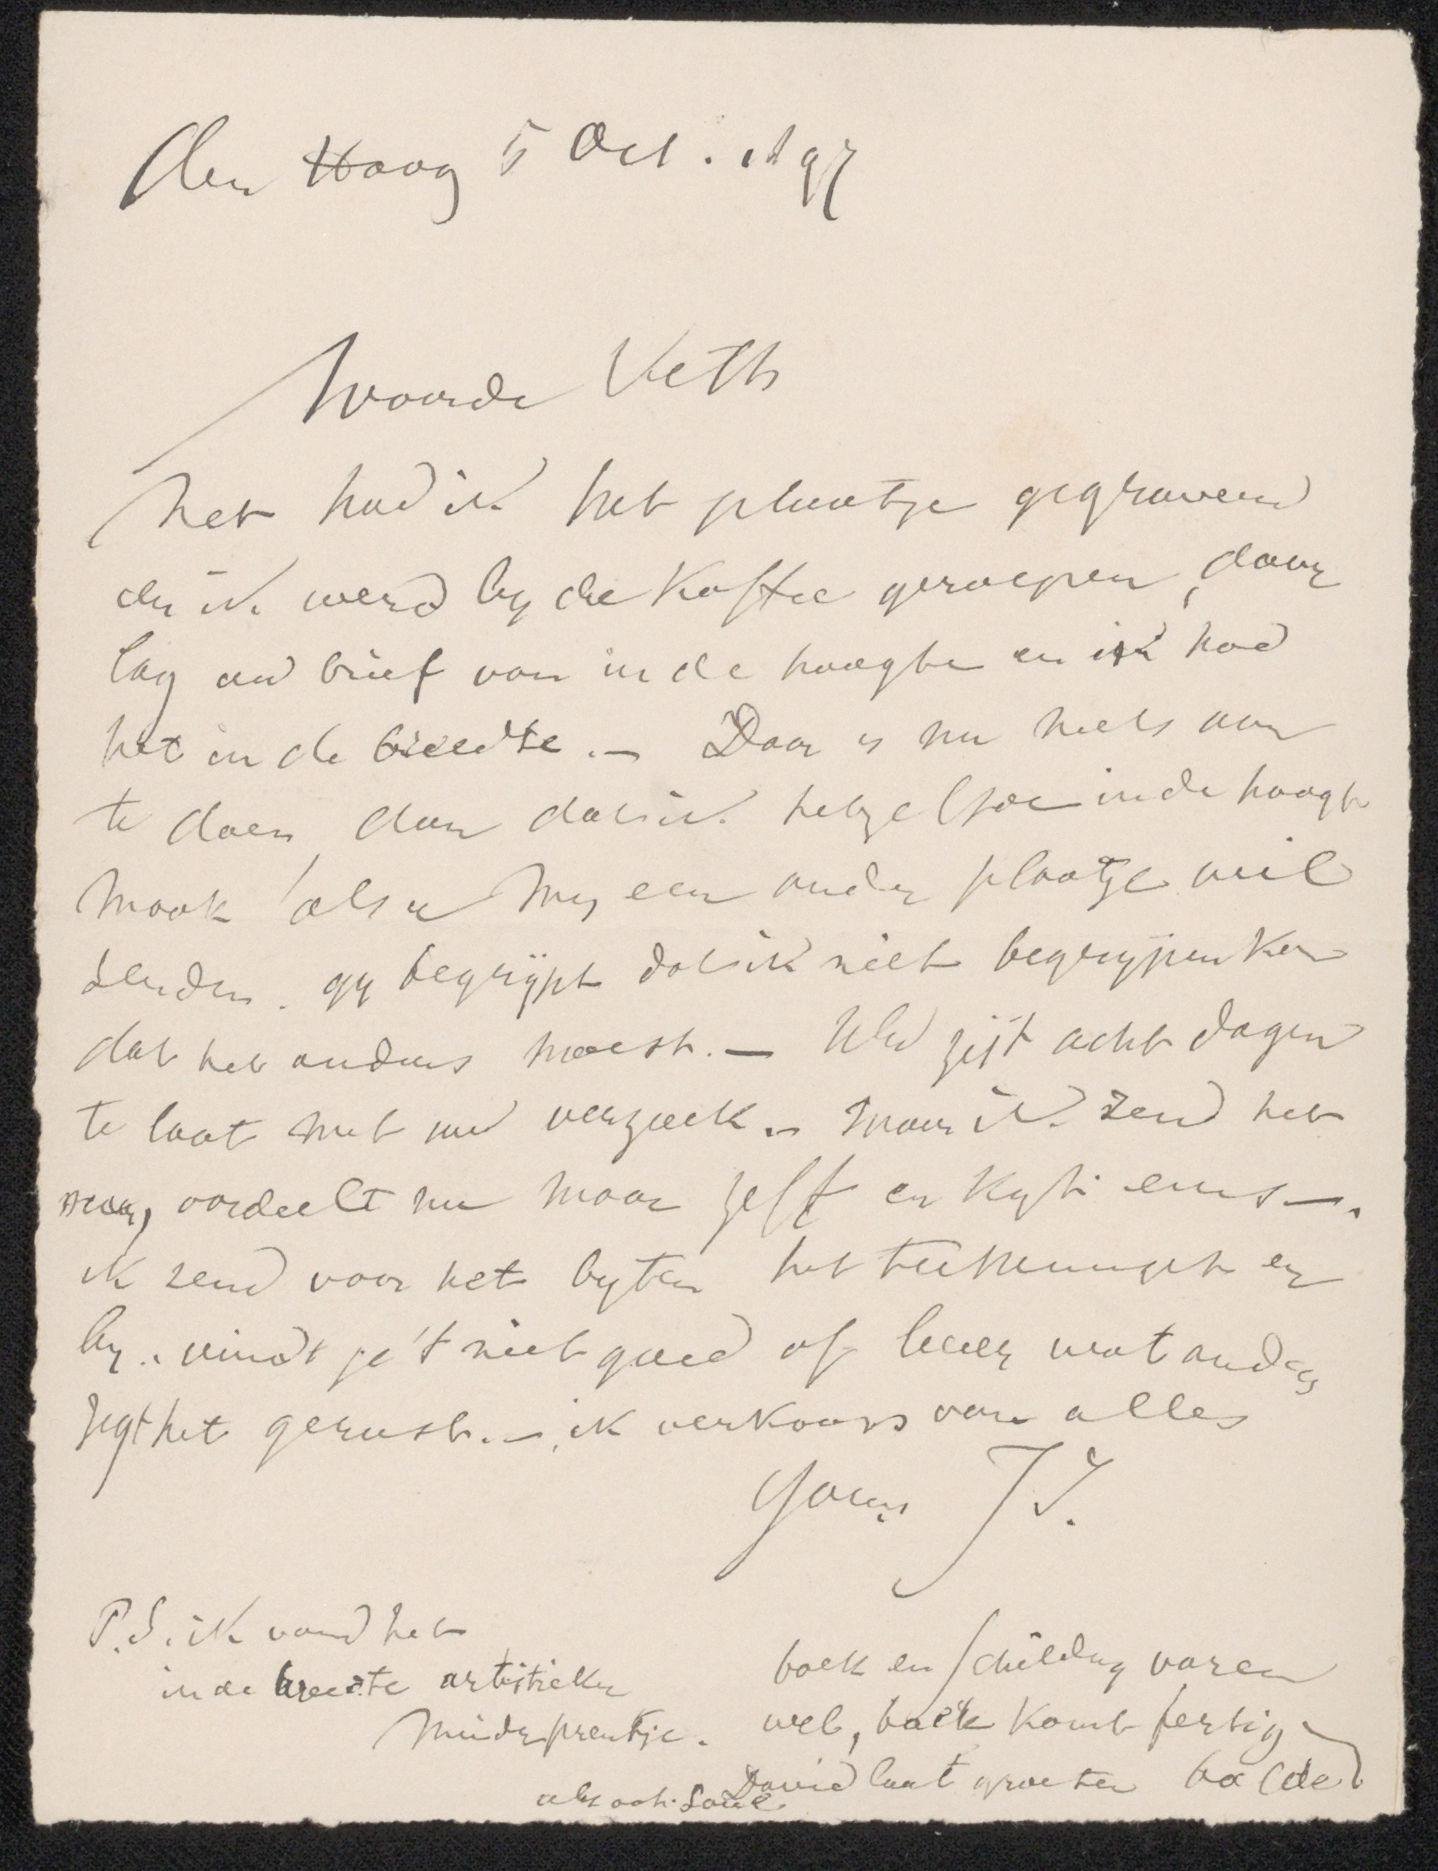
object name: letter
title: Brief aan Jan Veth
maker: jozef israëls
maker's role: draughtsman, painter, print maker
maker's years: 1824-1911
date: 1897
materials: ink, paper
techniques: pen, writing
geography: the hague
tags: dordrecht, painter, print maker, draughtsman, designer, jan veth, drawing, the graphic arts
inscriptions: collector's mark: ‘RPK’